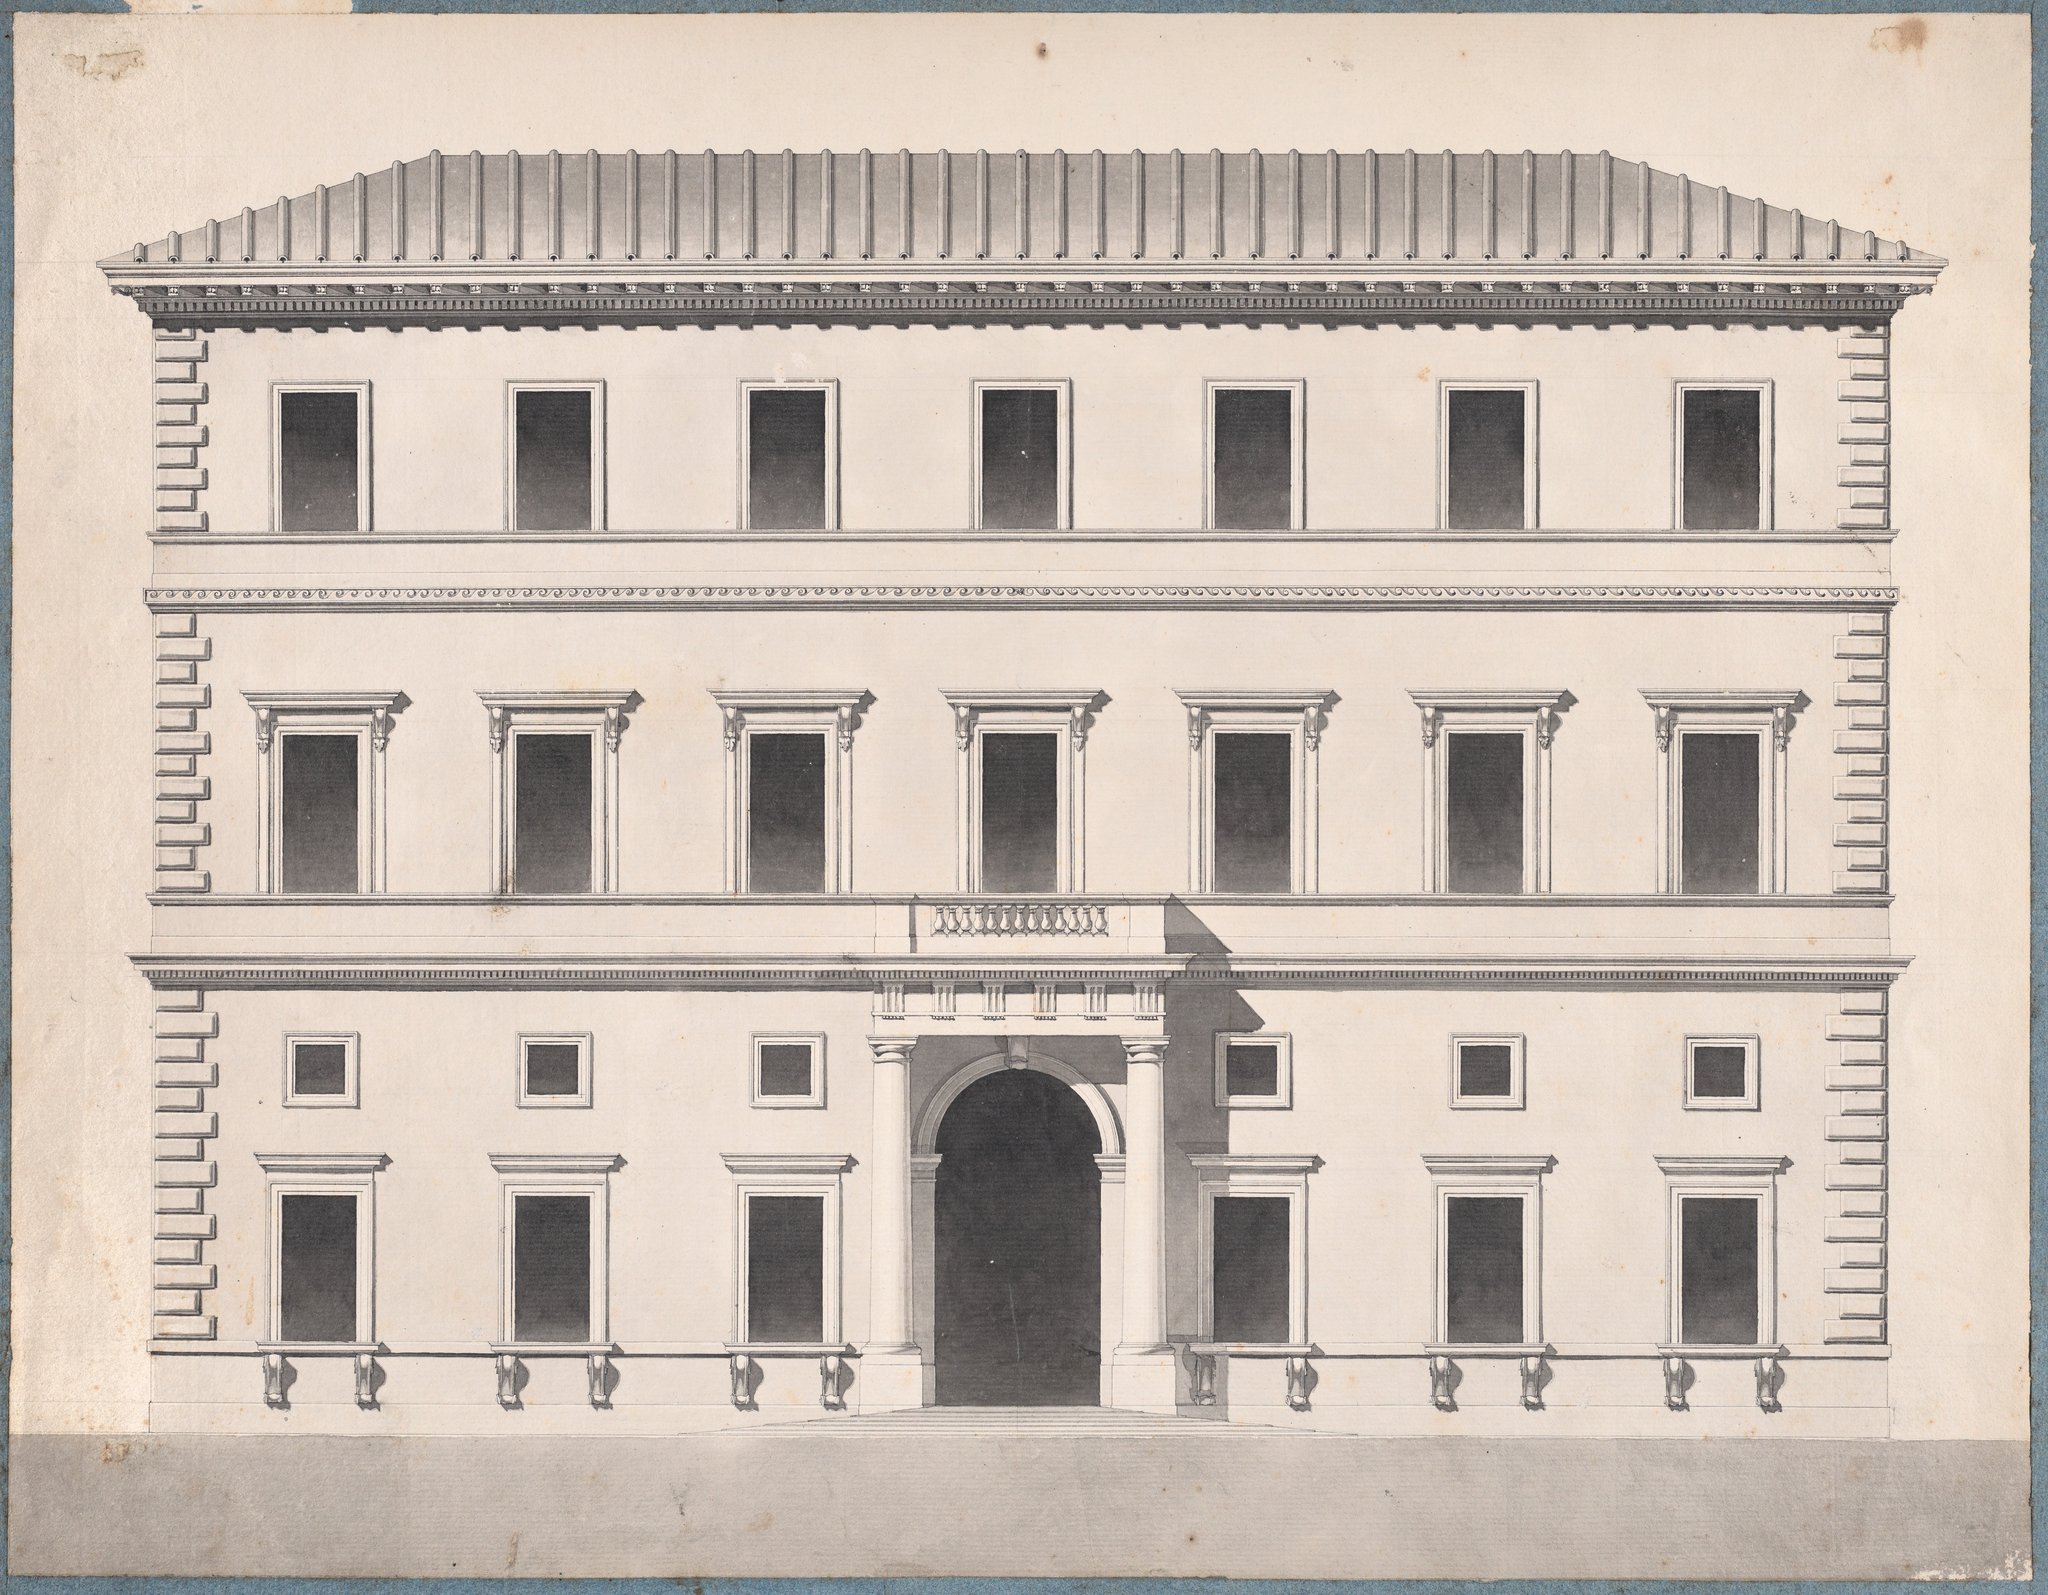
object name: drawing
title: Architectural Study of a Renaissance Palace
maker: anonymous, italian, 18th or early 19th century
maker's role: artist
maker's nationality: italian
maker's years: 1700-1850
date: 1750-1820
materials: ink, paper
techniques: pen, wash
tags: architecture,palaces